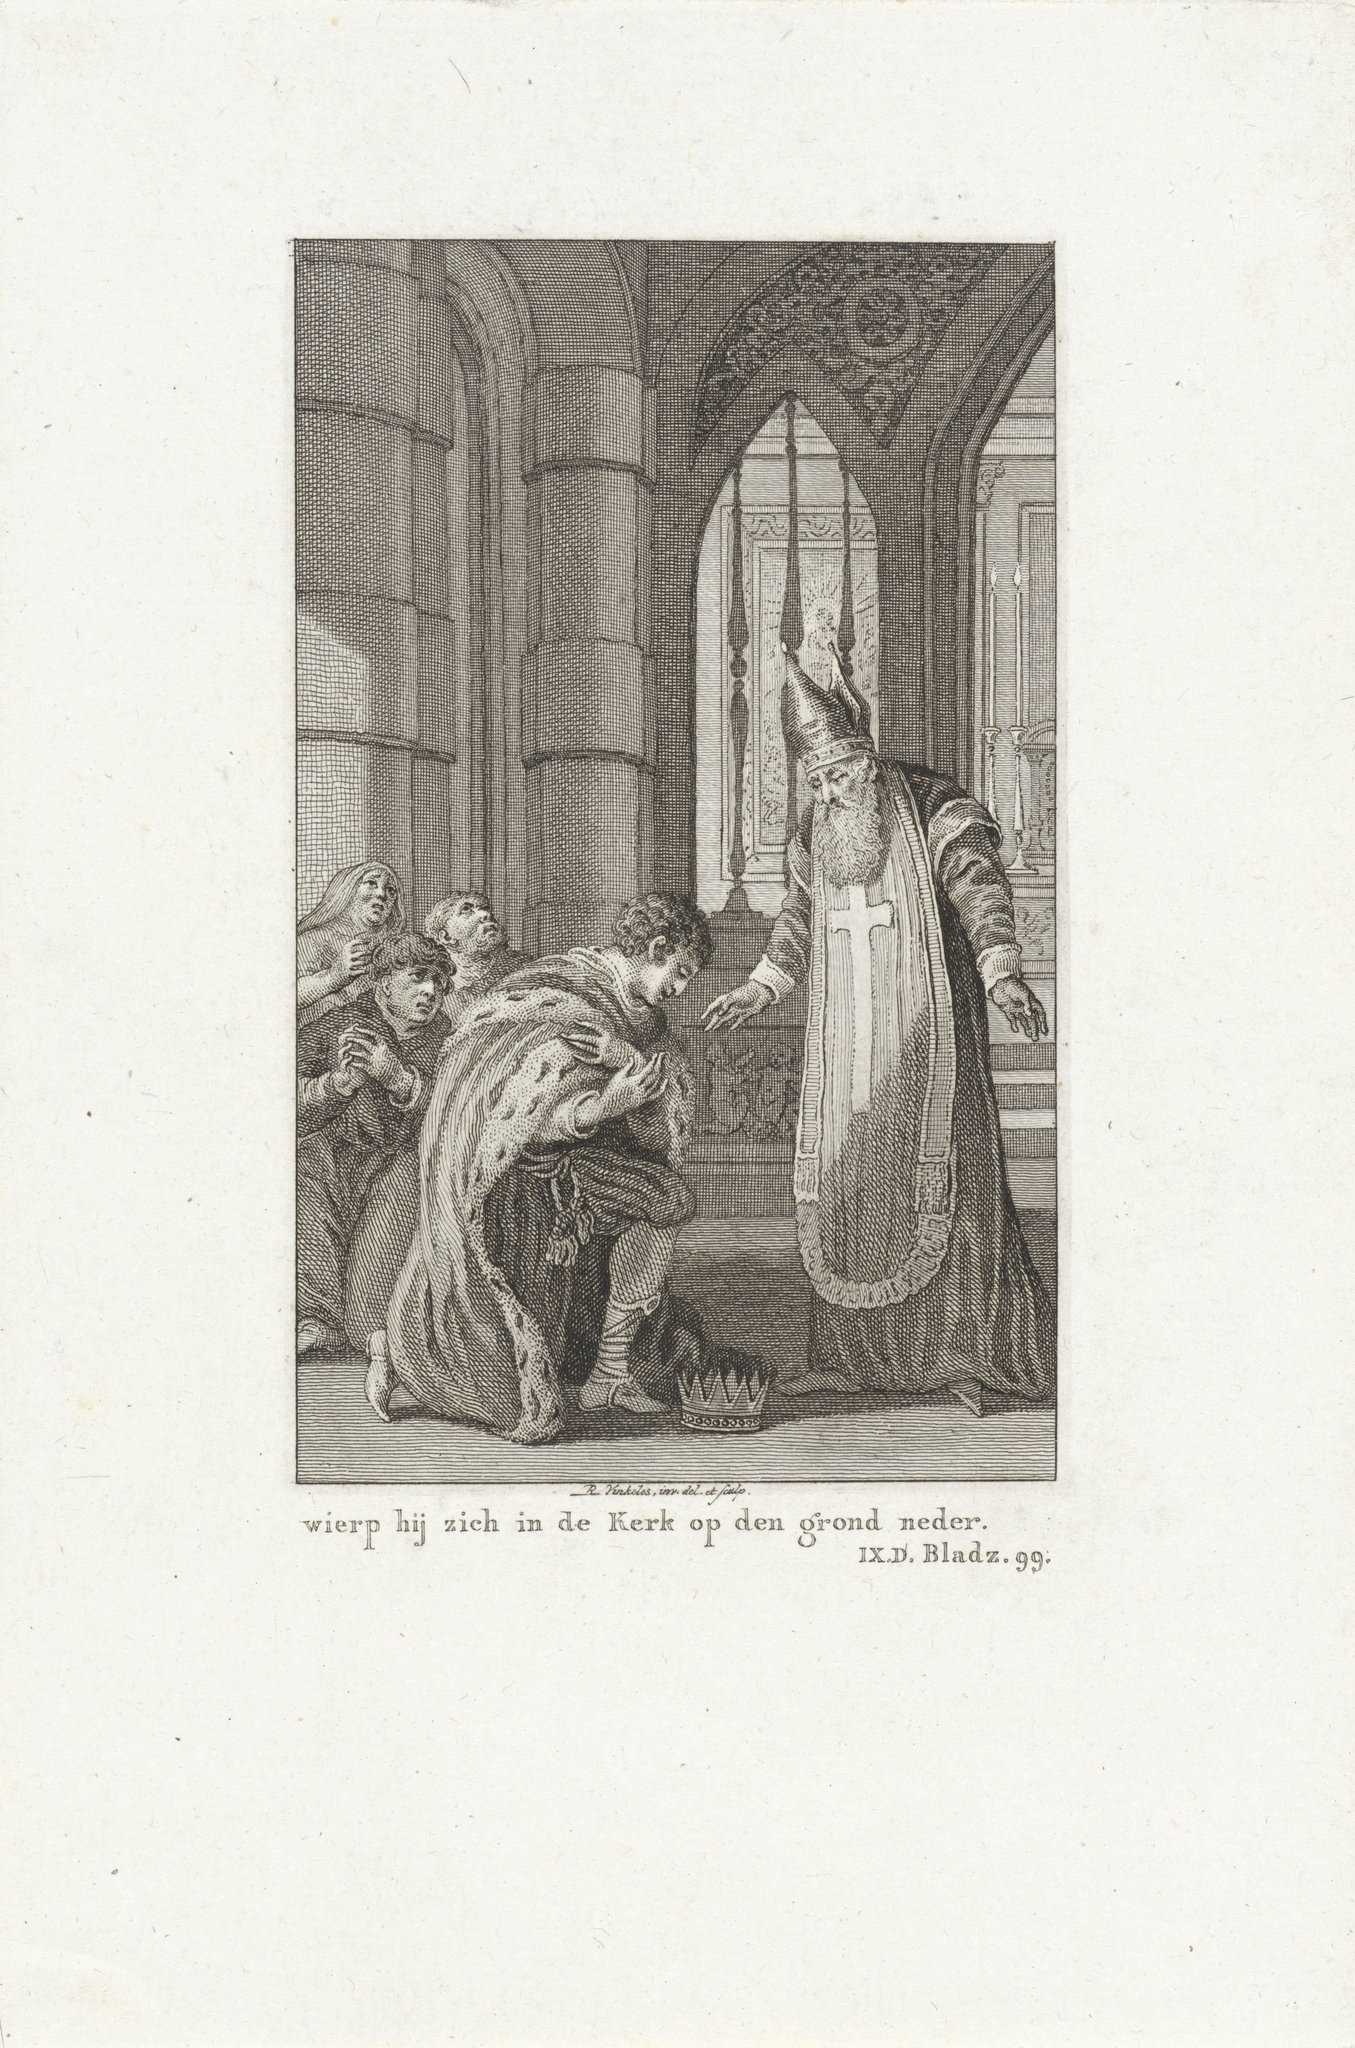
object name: print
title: Keizer Theodosius I werpt zich op zijn knieën voor Ambrosius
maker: reinier vinkeles (i)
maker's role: draughtsman, print maker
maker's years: 1741-1816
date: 1804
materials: paper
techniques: engraving, etching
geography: amsterdam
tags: crown (symbol of sovereignty), archbishop, bishop, etc. (roman catholic), ruler, sovereign, kneeling figure, one person praying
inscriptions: collector's mark: Lugt 240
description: In 390 in een kerk, knielt keizer Theodosius I voor bisschop Ambrosius om vergeving voor zijn zonden te vragen. Zijn kroon ligt voor hem op de grond. Achter Theodosius knielen nog drie anderen.